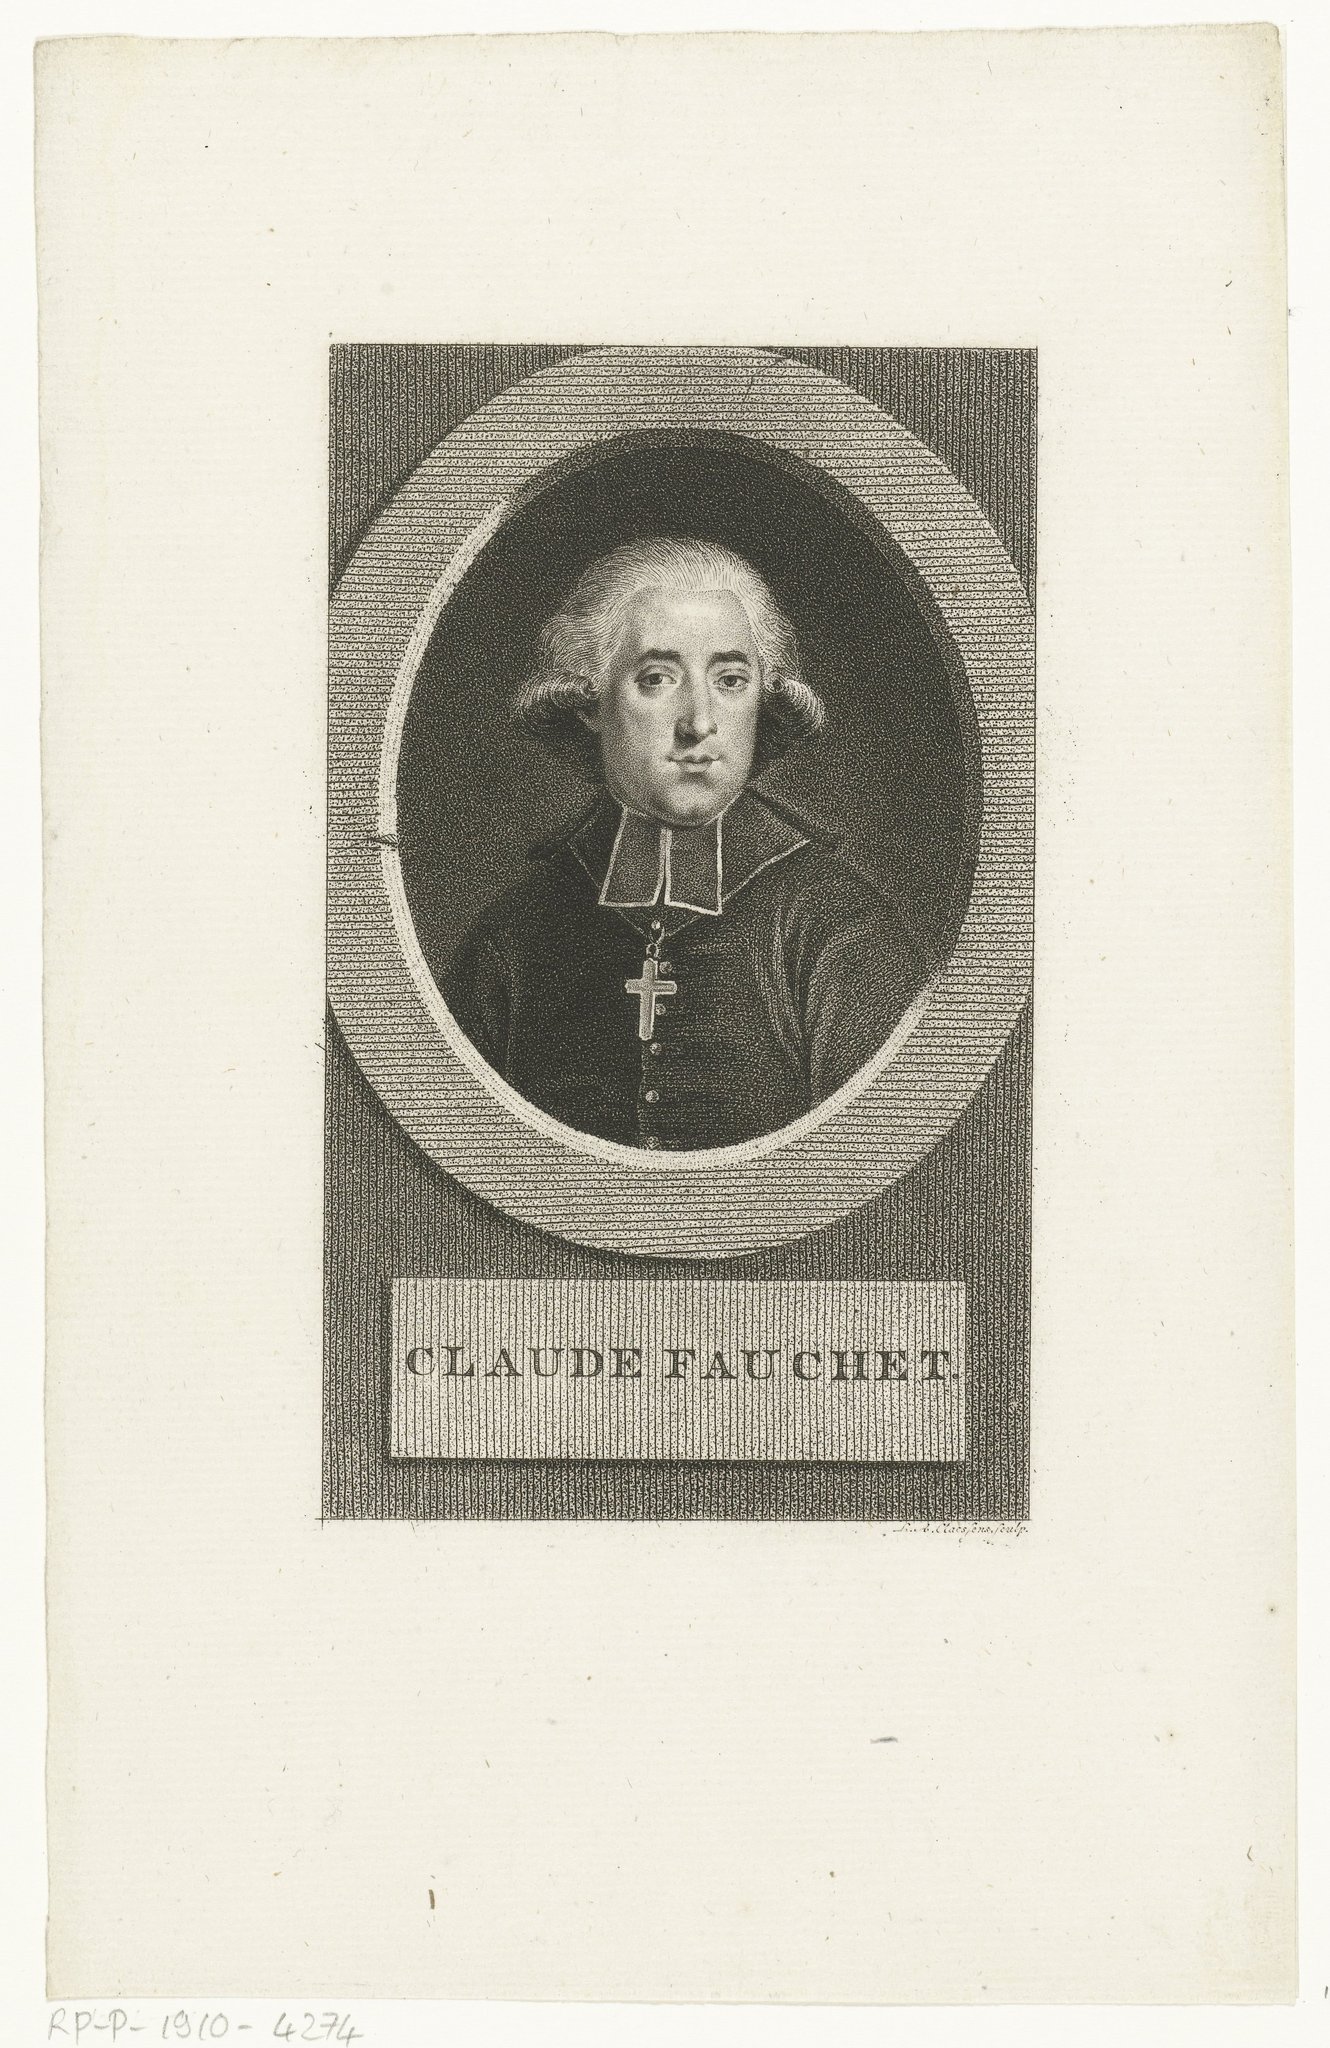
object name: print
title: Portret van Claude Fauchet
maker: lambertus antonius claessens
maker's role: draughtsman, print maker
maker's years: 1763-1834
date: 1792-1808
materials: paper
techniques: engraving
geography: amsterdam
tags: bisschop, claude fauchet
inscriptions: collector's mark: Lugt 2228